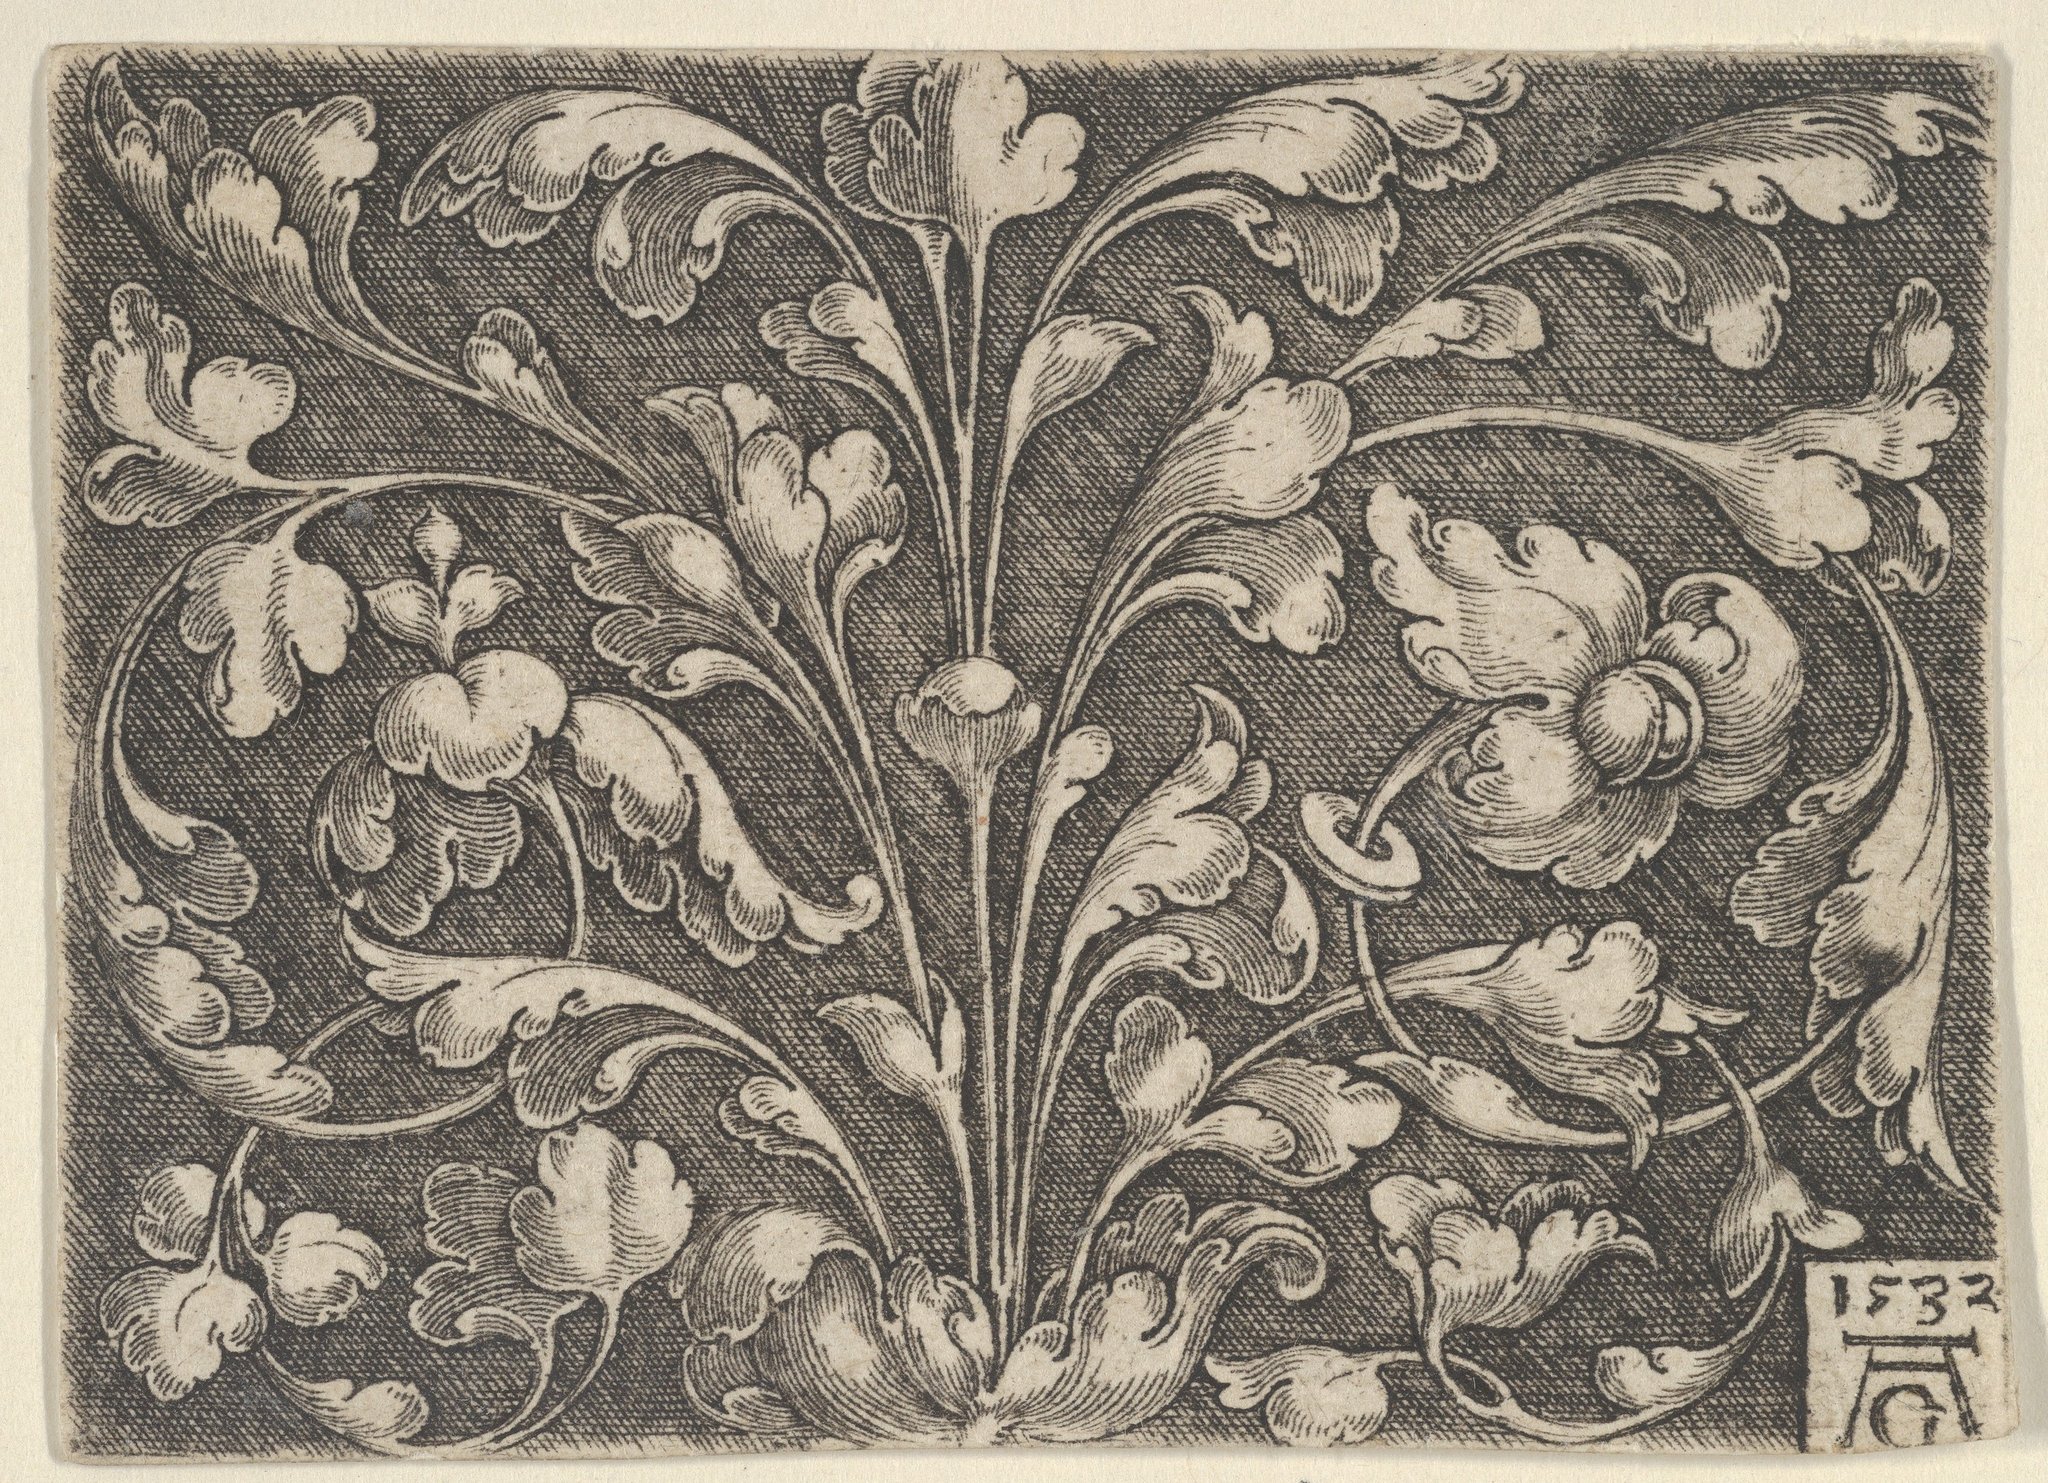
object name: print ornament architecture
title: Horizontal Panel with Tendrils Rising from Center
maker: heinrich aldegrever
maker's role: artist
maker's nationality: german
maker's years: 1502-1561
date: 1532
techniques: engraving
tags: leaves